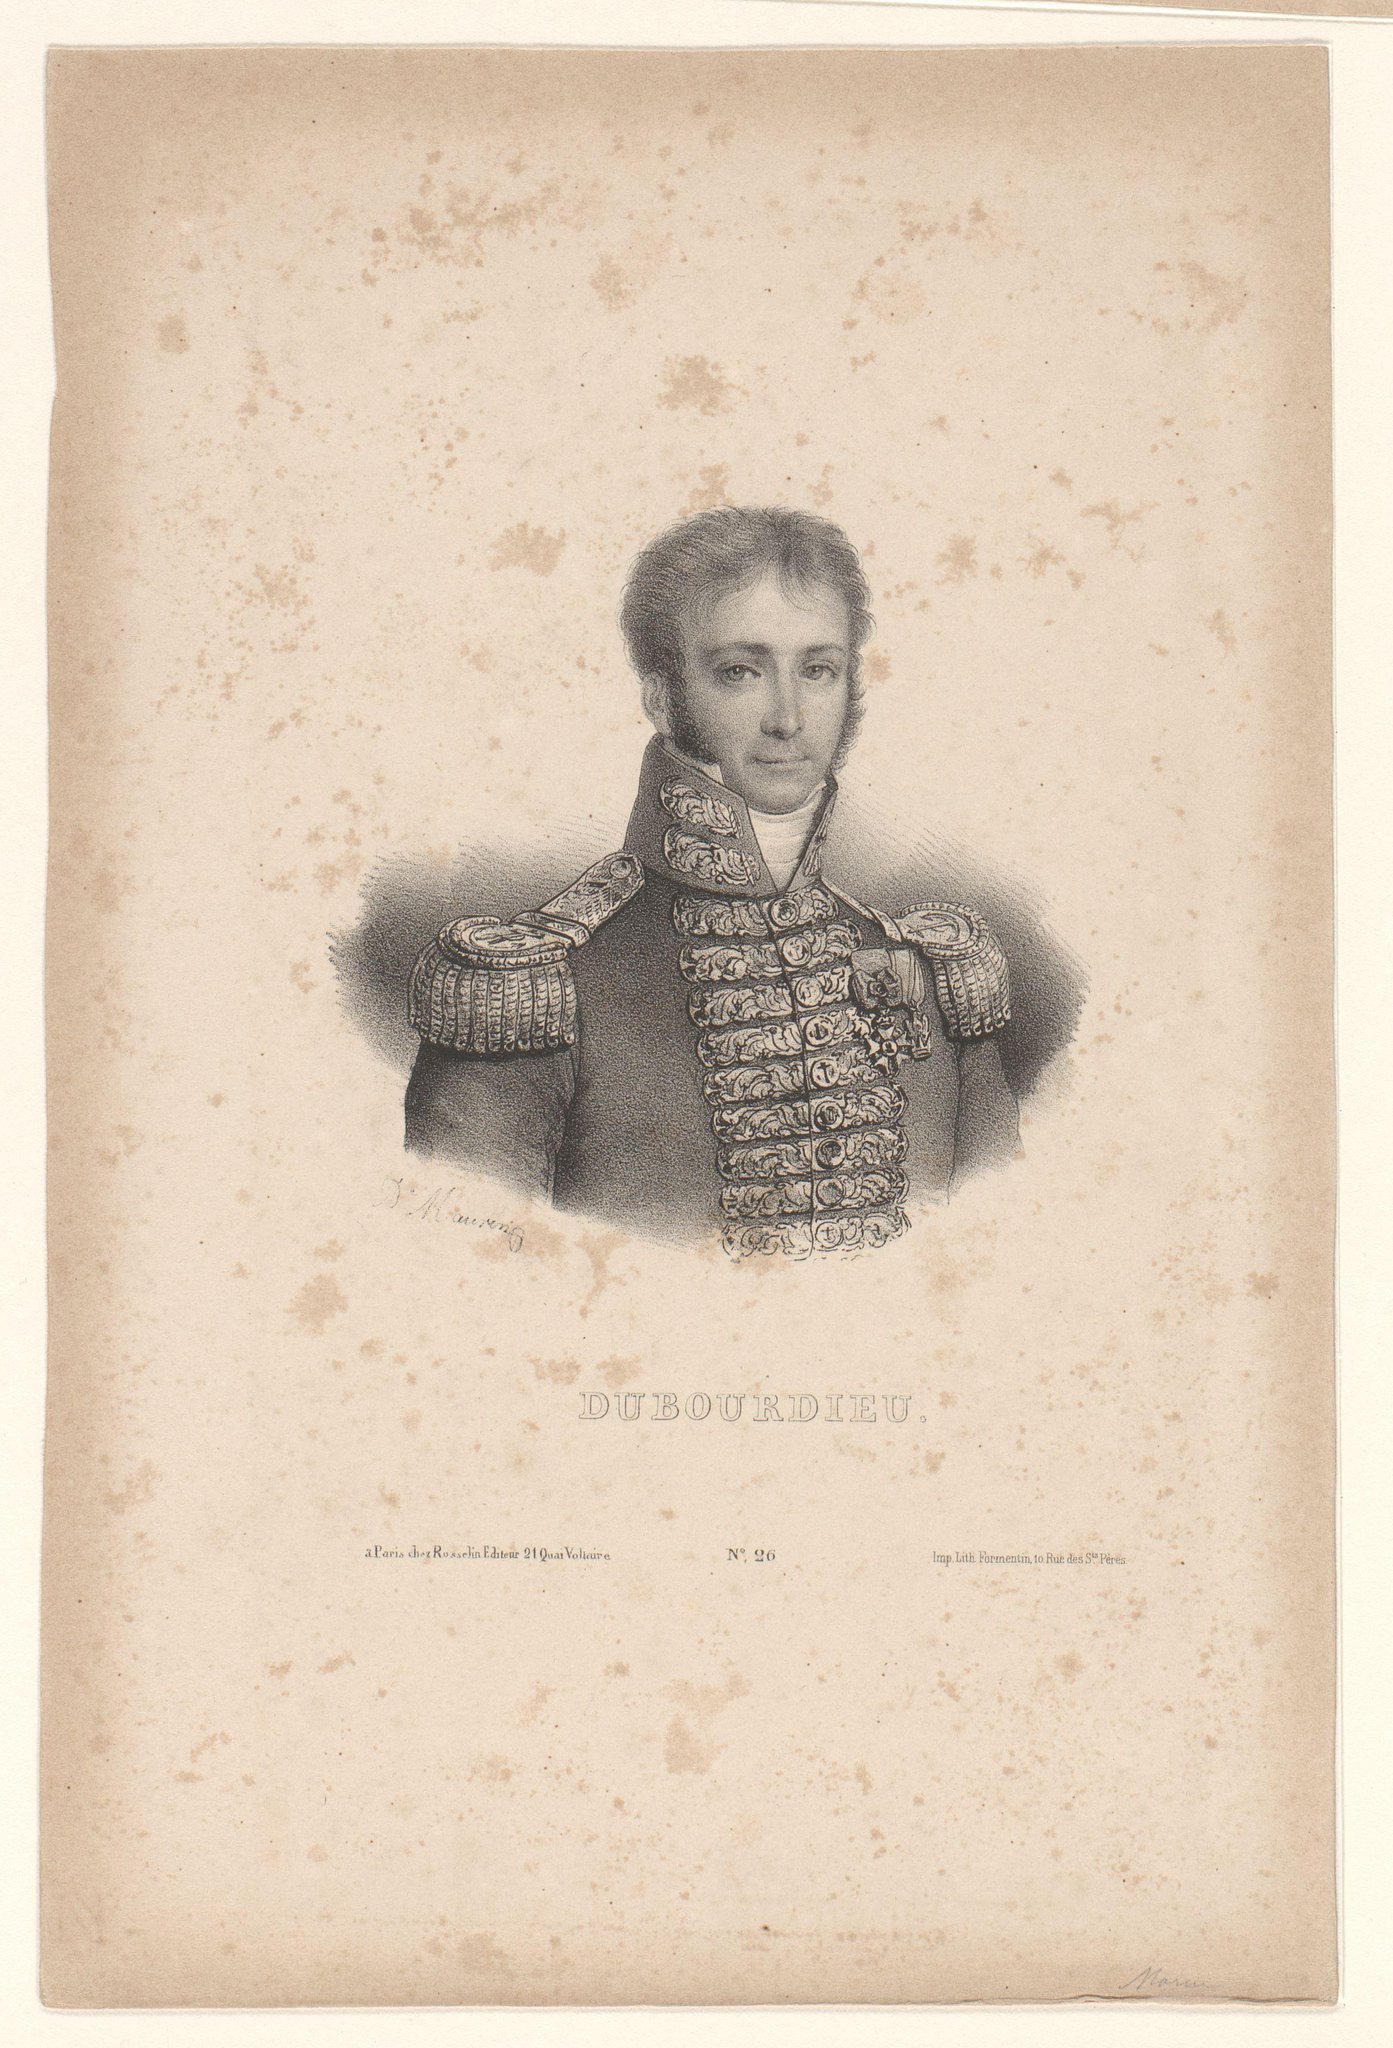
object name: print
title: Portret van marine-officier Bernard Dubourdieu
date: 1836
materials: paper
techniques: lithograph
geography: paris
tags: historical persons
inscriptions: collector's mark: Lugt 2228